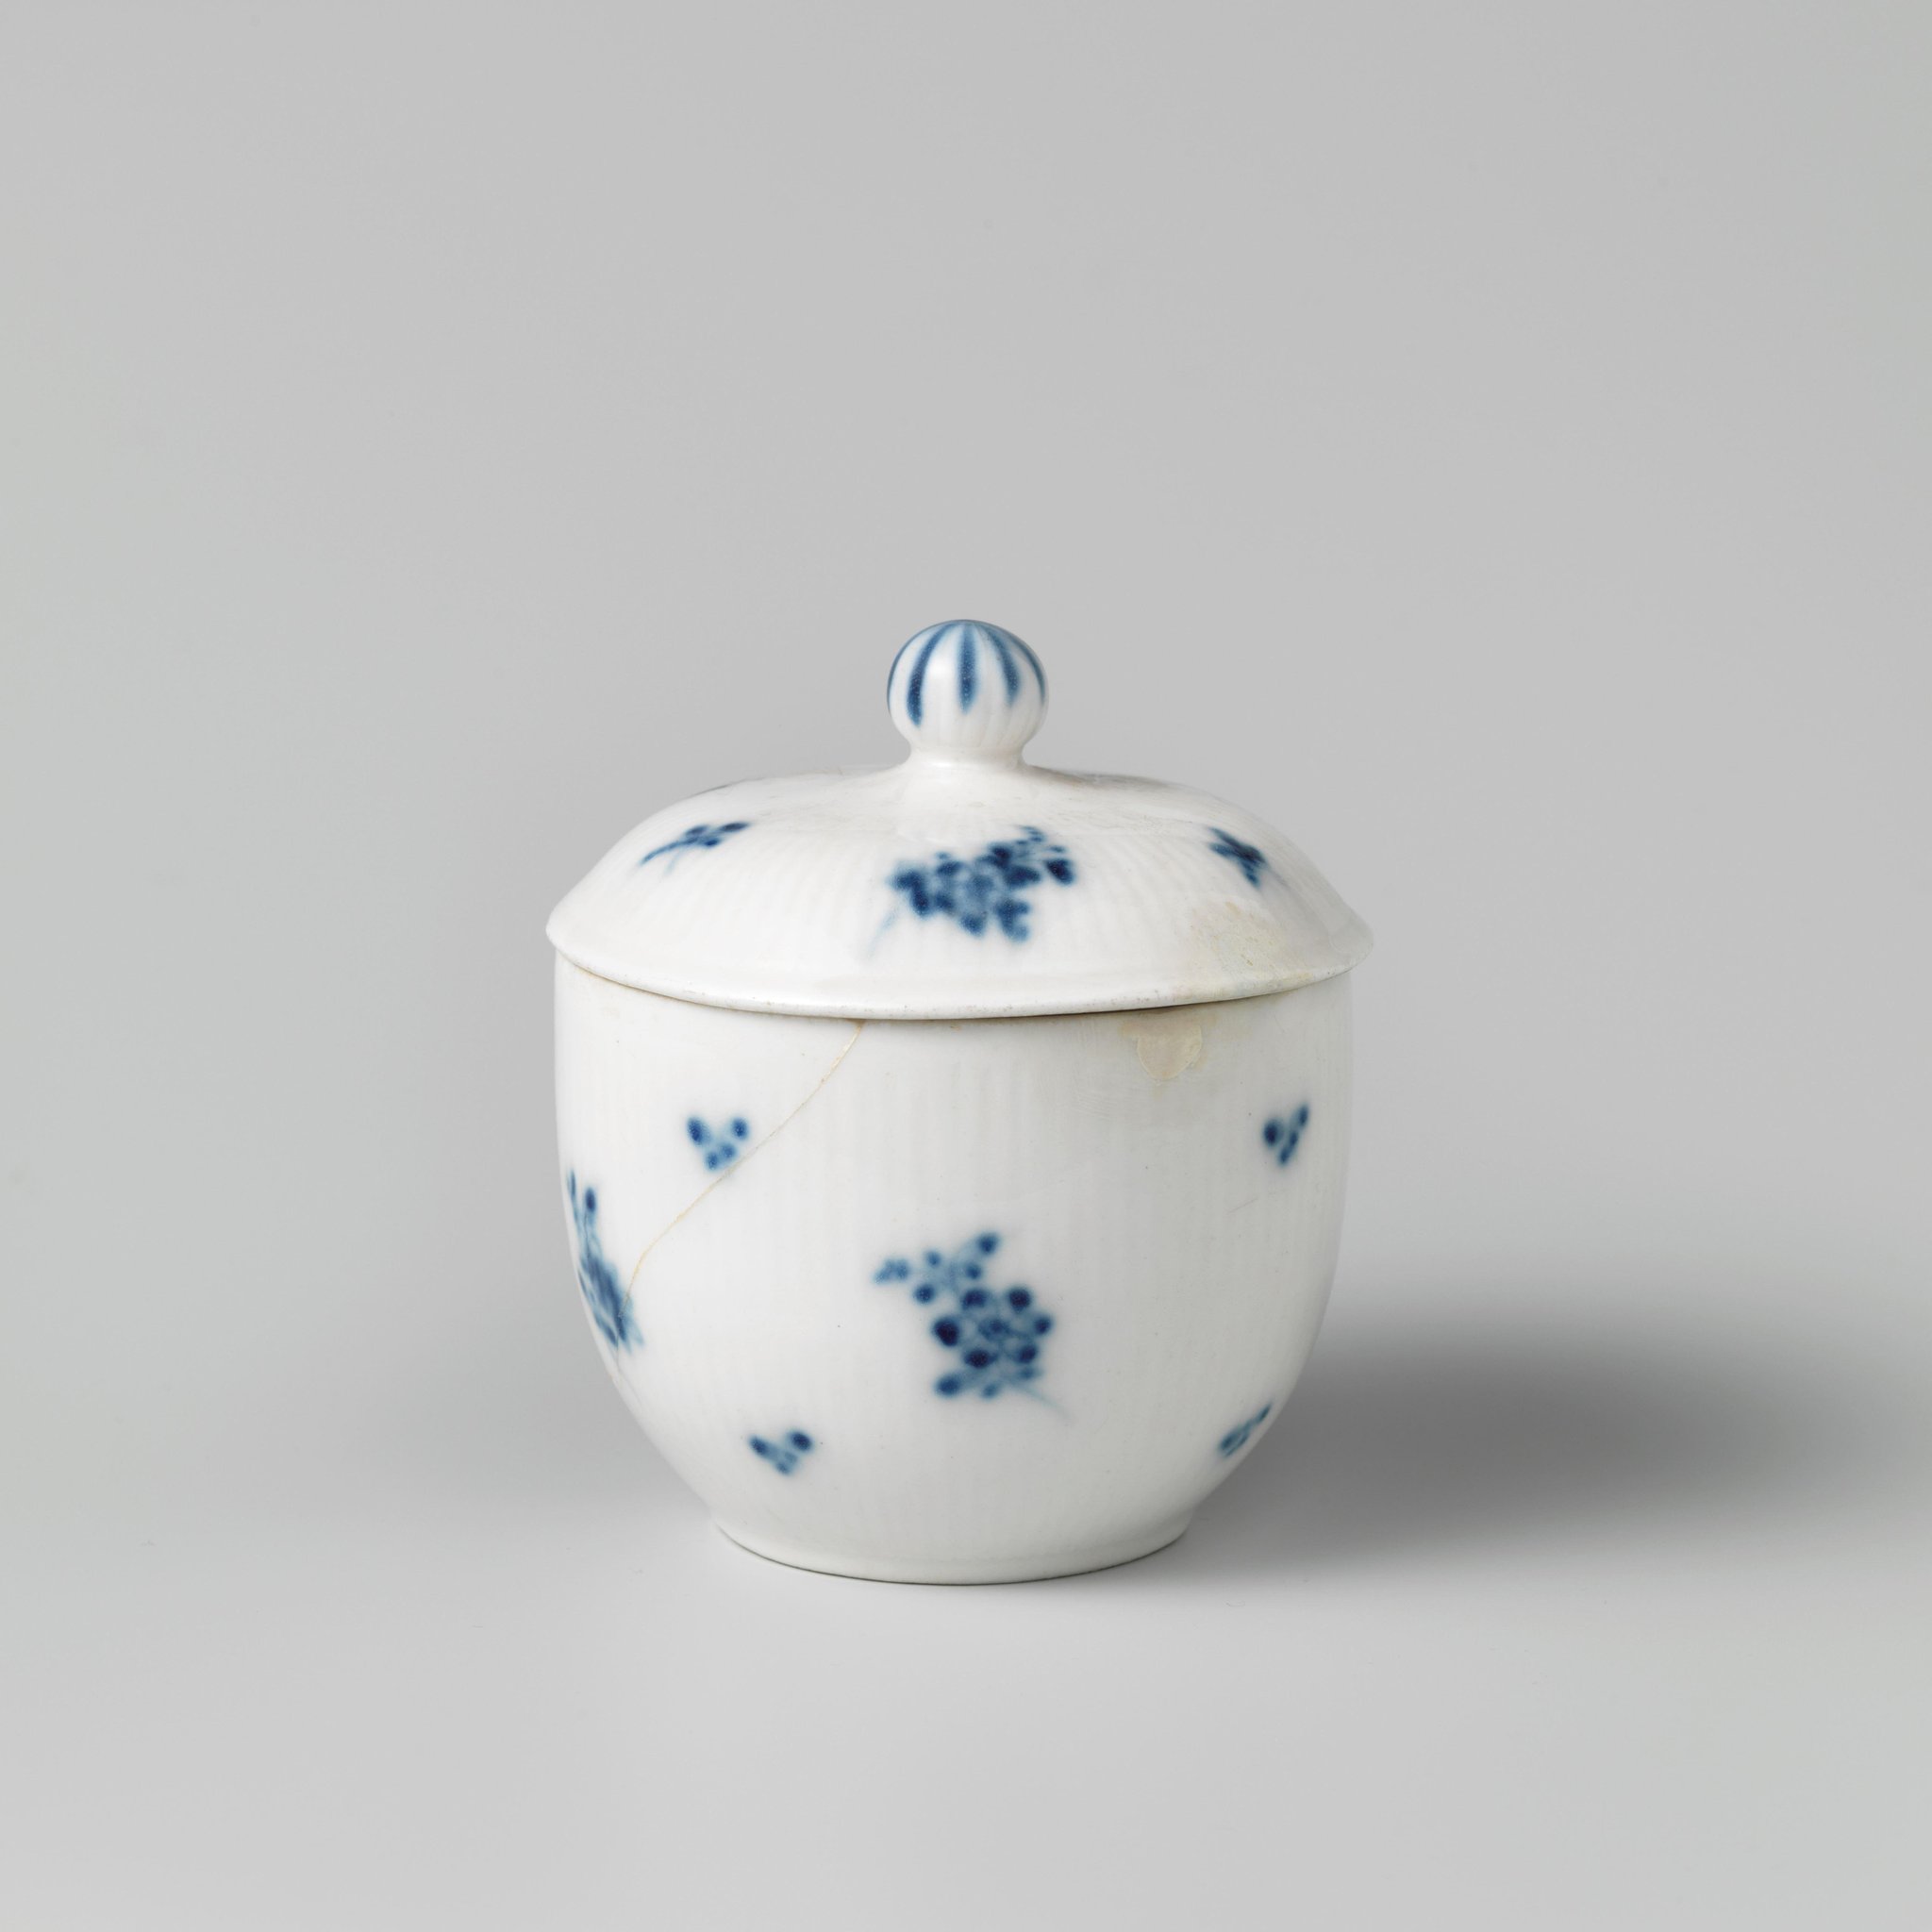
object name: sugar box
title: Suikerpot, beschilderd met strooibloemen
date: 1784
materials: porcelain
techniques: painted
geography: loosdrecht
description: Suikerpot geribd met een blauw strooipatroon van bloemen onder het glazuur. Gemerkt: koffiekan Amstel in blauw, theepot M:O L in blauw en ingegrift, melkkan MOL en Amstel in blauw en suikerpot * M:OL in blauw en ingegrift M:OL L80.